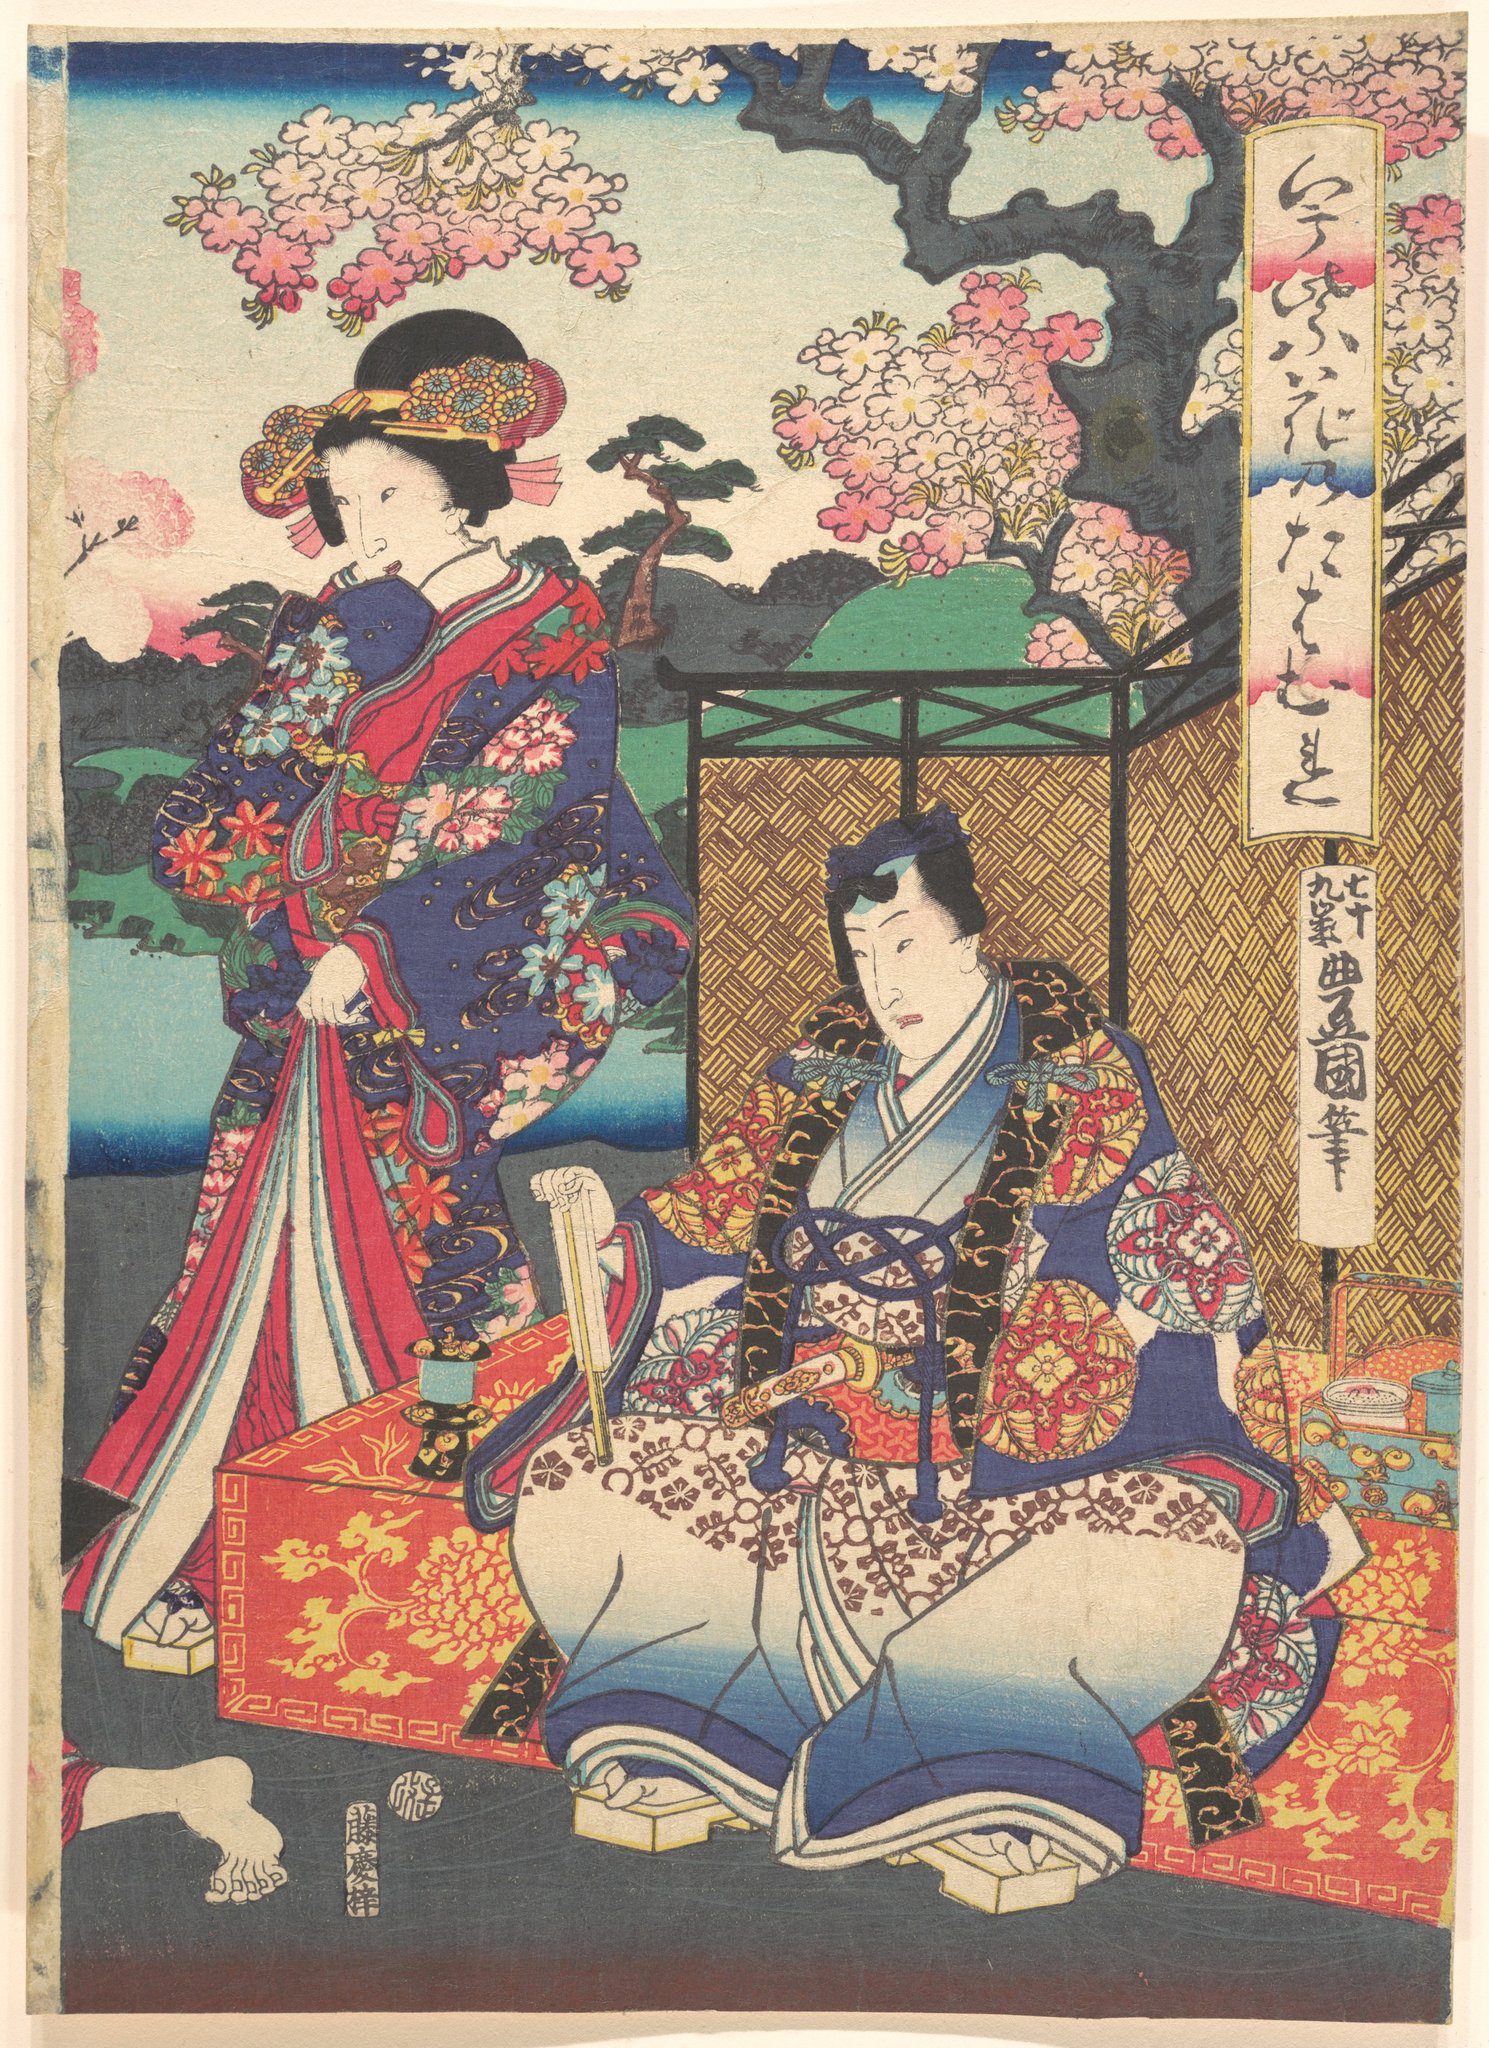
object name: print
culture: japanese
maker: utagawa kunisada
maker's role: artist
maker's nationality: japanese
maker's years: 1786-1864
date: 1786-1854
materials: ink, paper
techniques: woodblock print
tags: men,women,flowers,trees